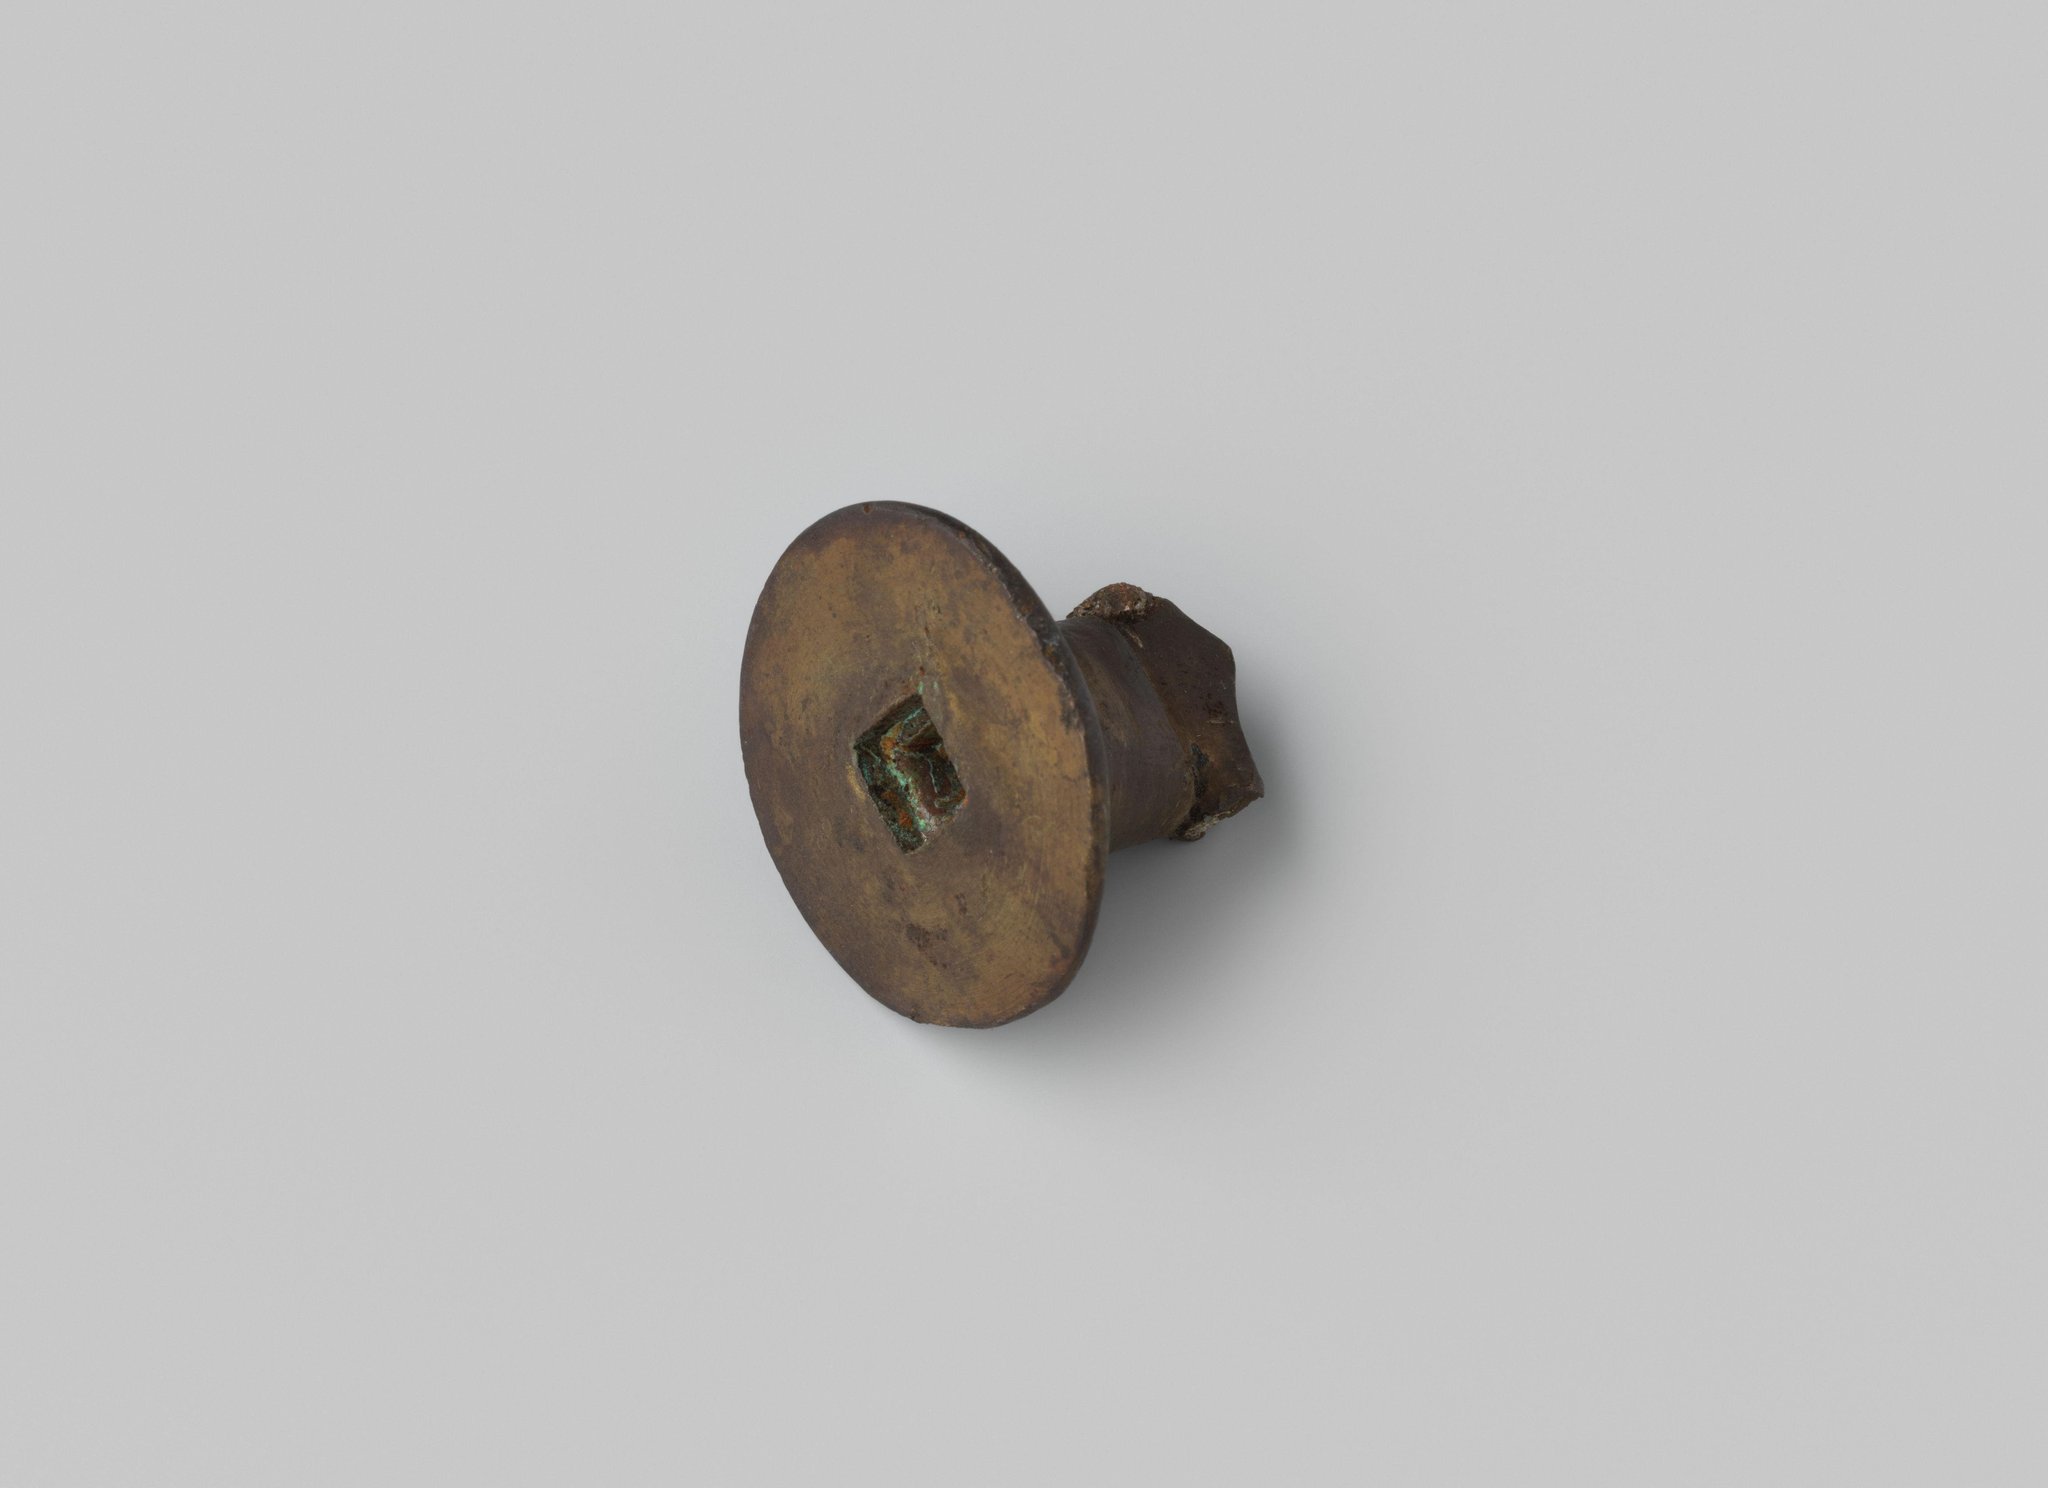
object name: handle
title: Ringhandvat uit het wrak van de Oost-Indiëvaarder Hollandia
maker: Anonymous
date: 1700-1743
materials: copper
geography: netherlands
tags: verenigde oostindische compagnie, hollandia (schip), annet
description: Fittings, handles, loop handle; fragm, id. NG 1979-223H2806: shaft on a circular base without holes, ring broken off.